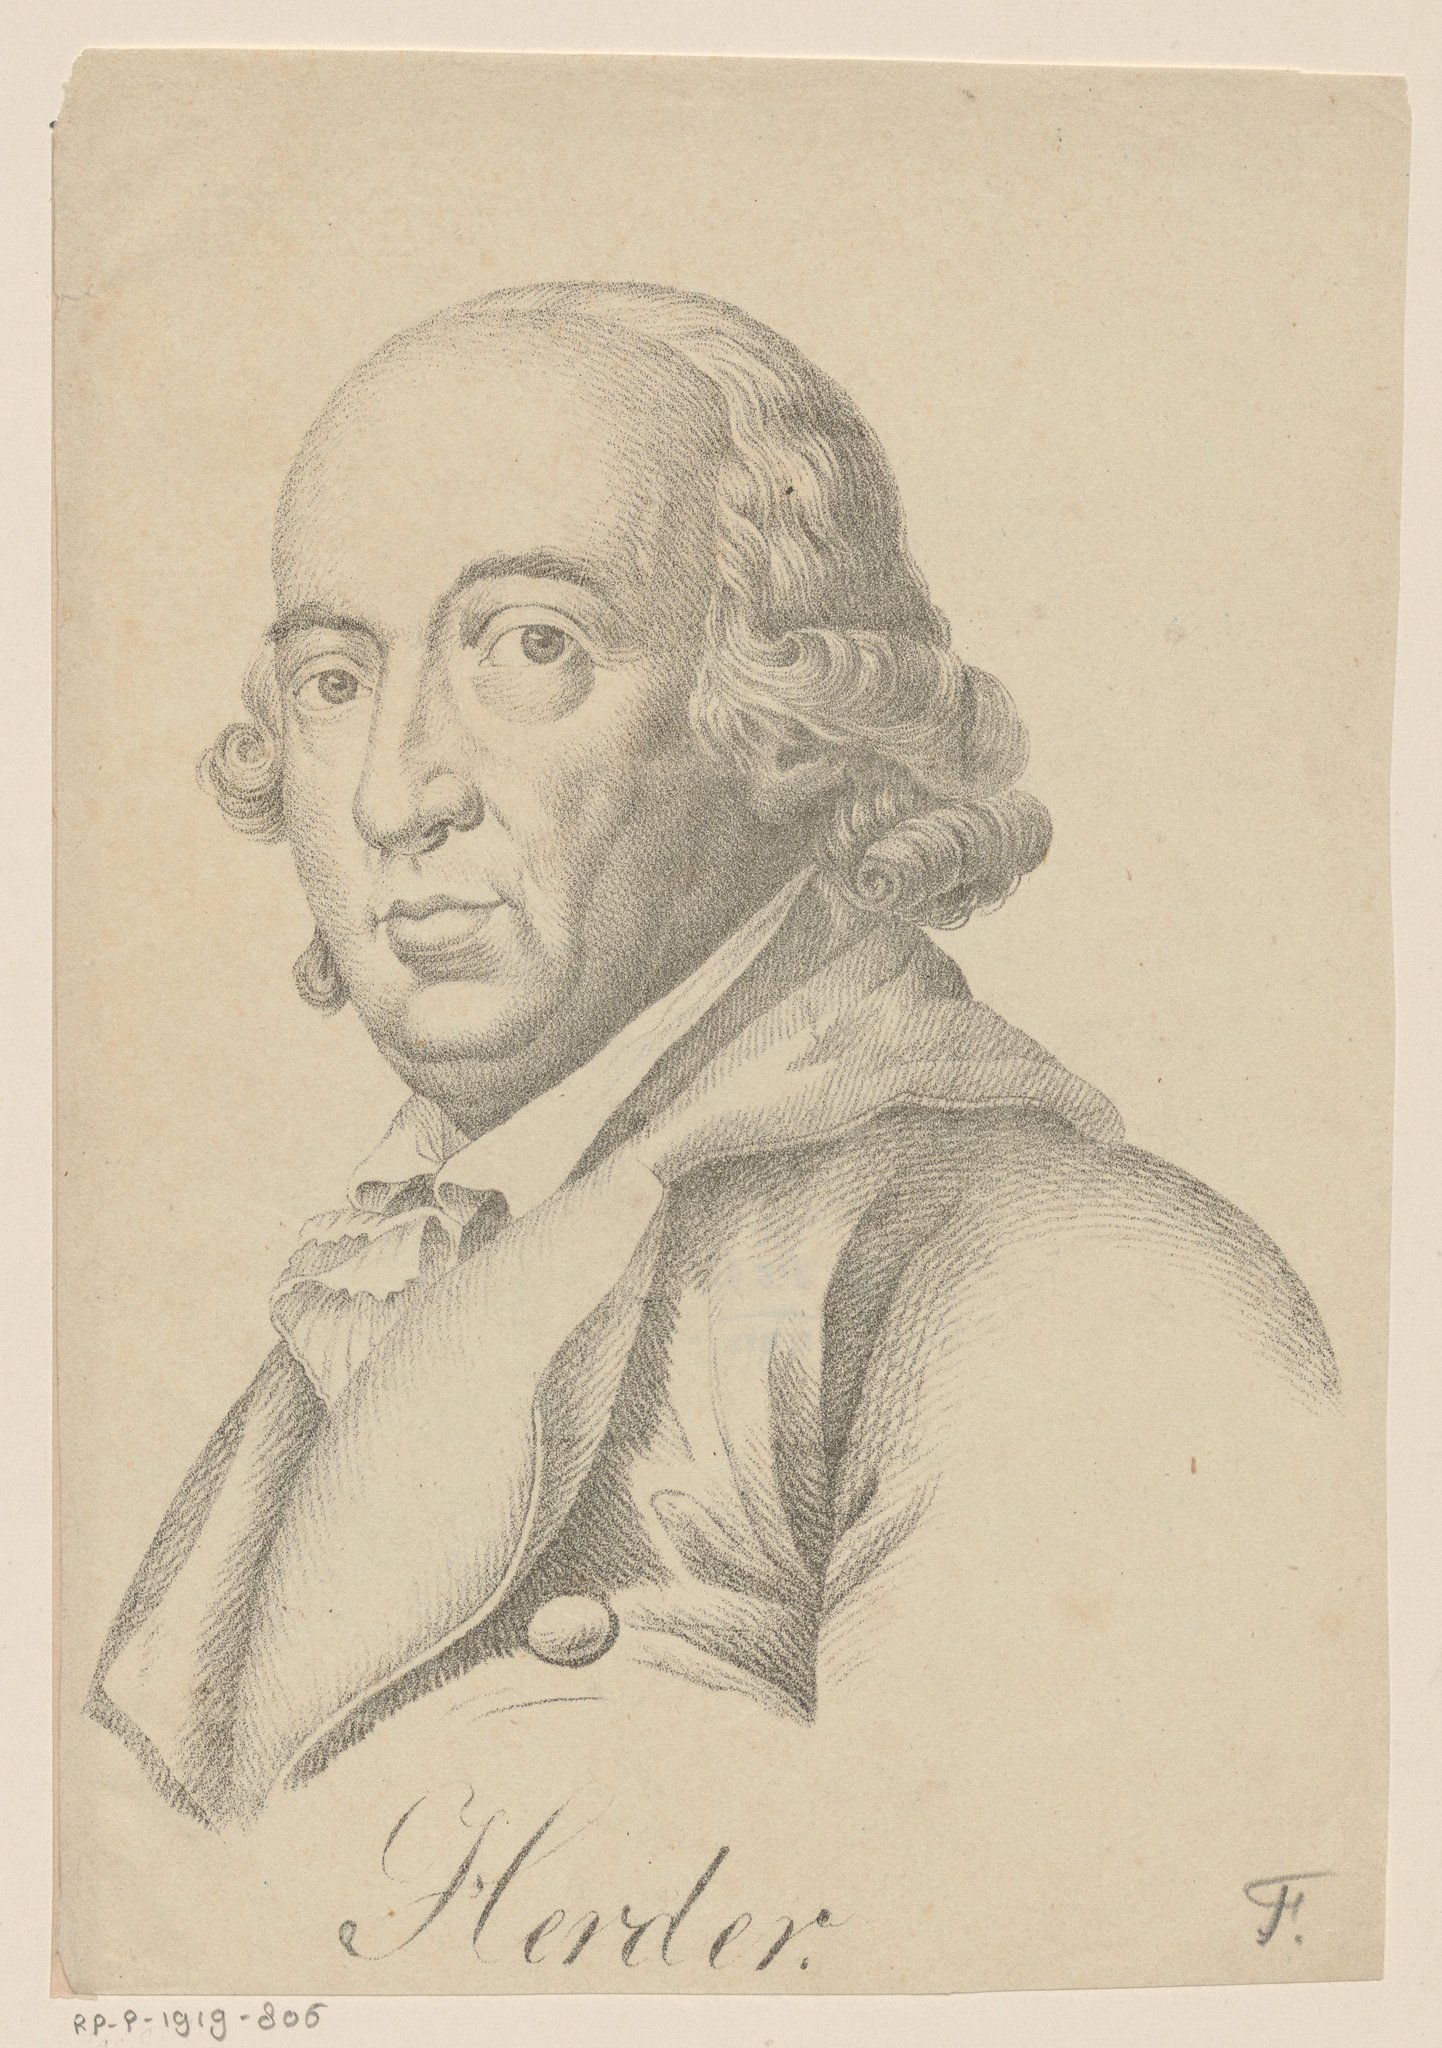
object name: print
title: Portret van Johann Gottfried von Herder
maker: Anonymous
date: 1825-1874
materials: paper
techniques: lithograph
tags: historical persons, writer, poet, author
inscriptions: collector's mark: Lugt 2228